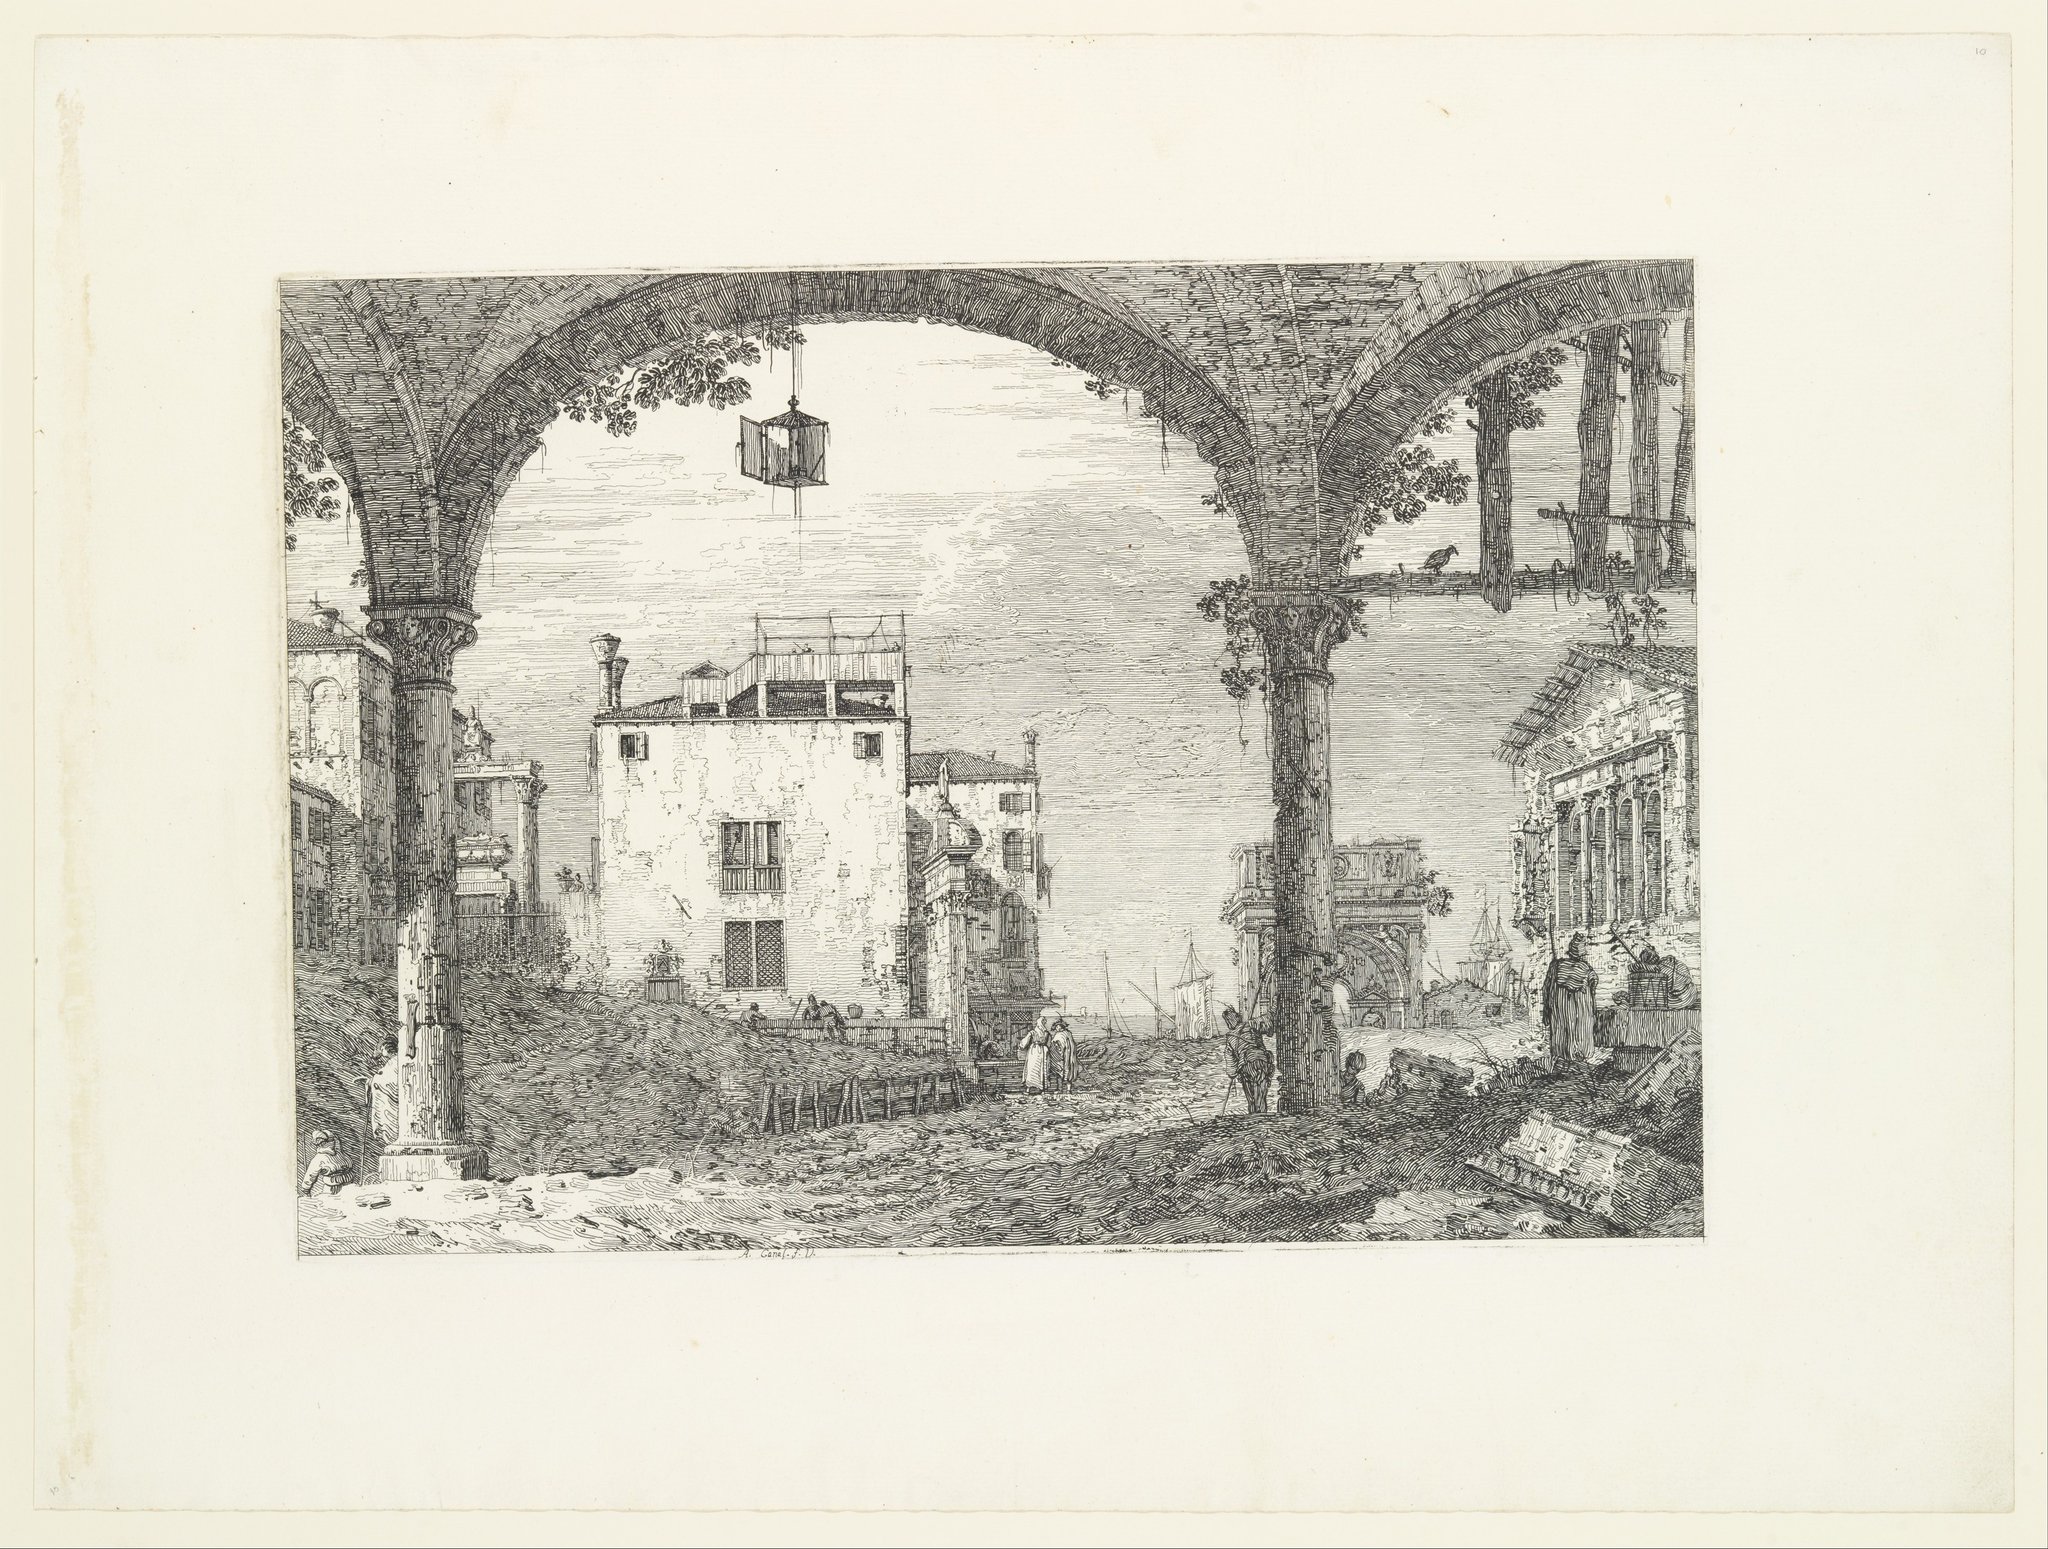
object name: print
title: A three-arched portico with an open lantern hanging at center, a triumphal arch and ruins of a classical temple in the background, from "Views" (Vedute altre prese da i luoghi altre ideate da Antonio Canal)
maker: canaletto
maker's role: artist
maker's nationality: italian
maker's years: 1697-1768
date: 1735-1746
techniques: etching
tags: arches,buildings,ruins